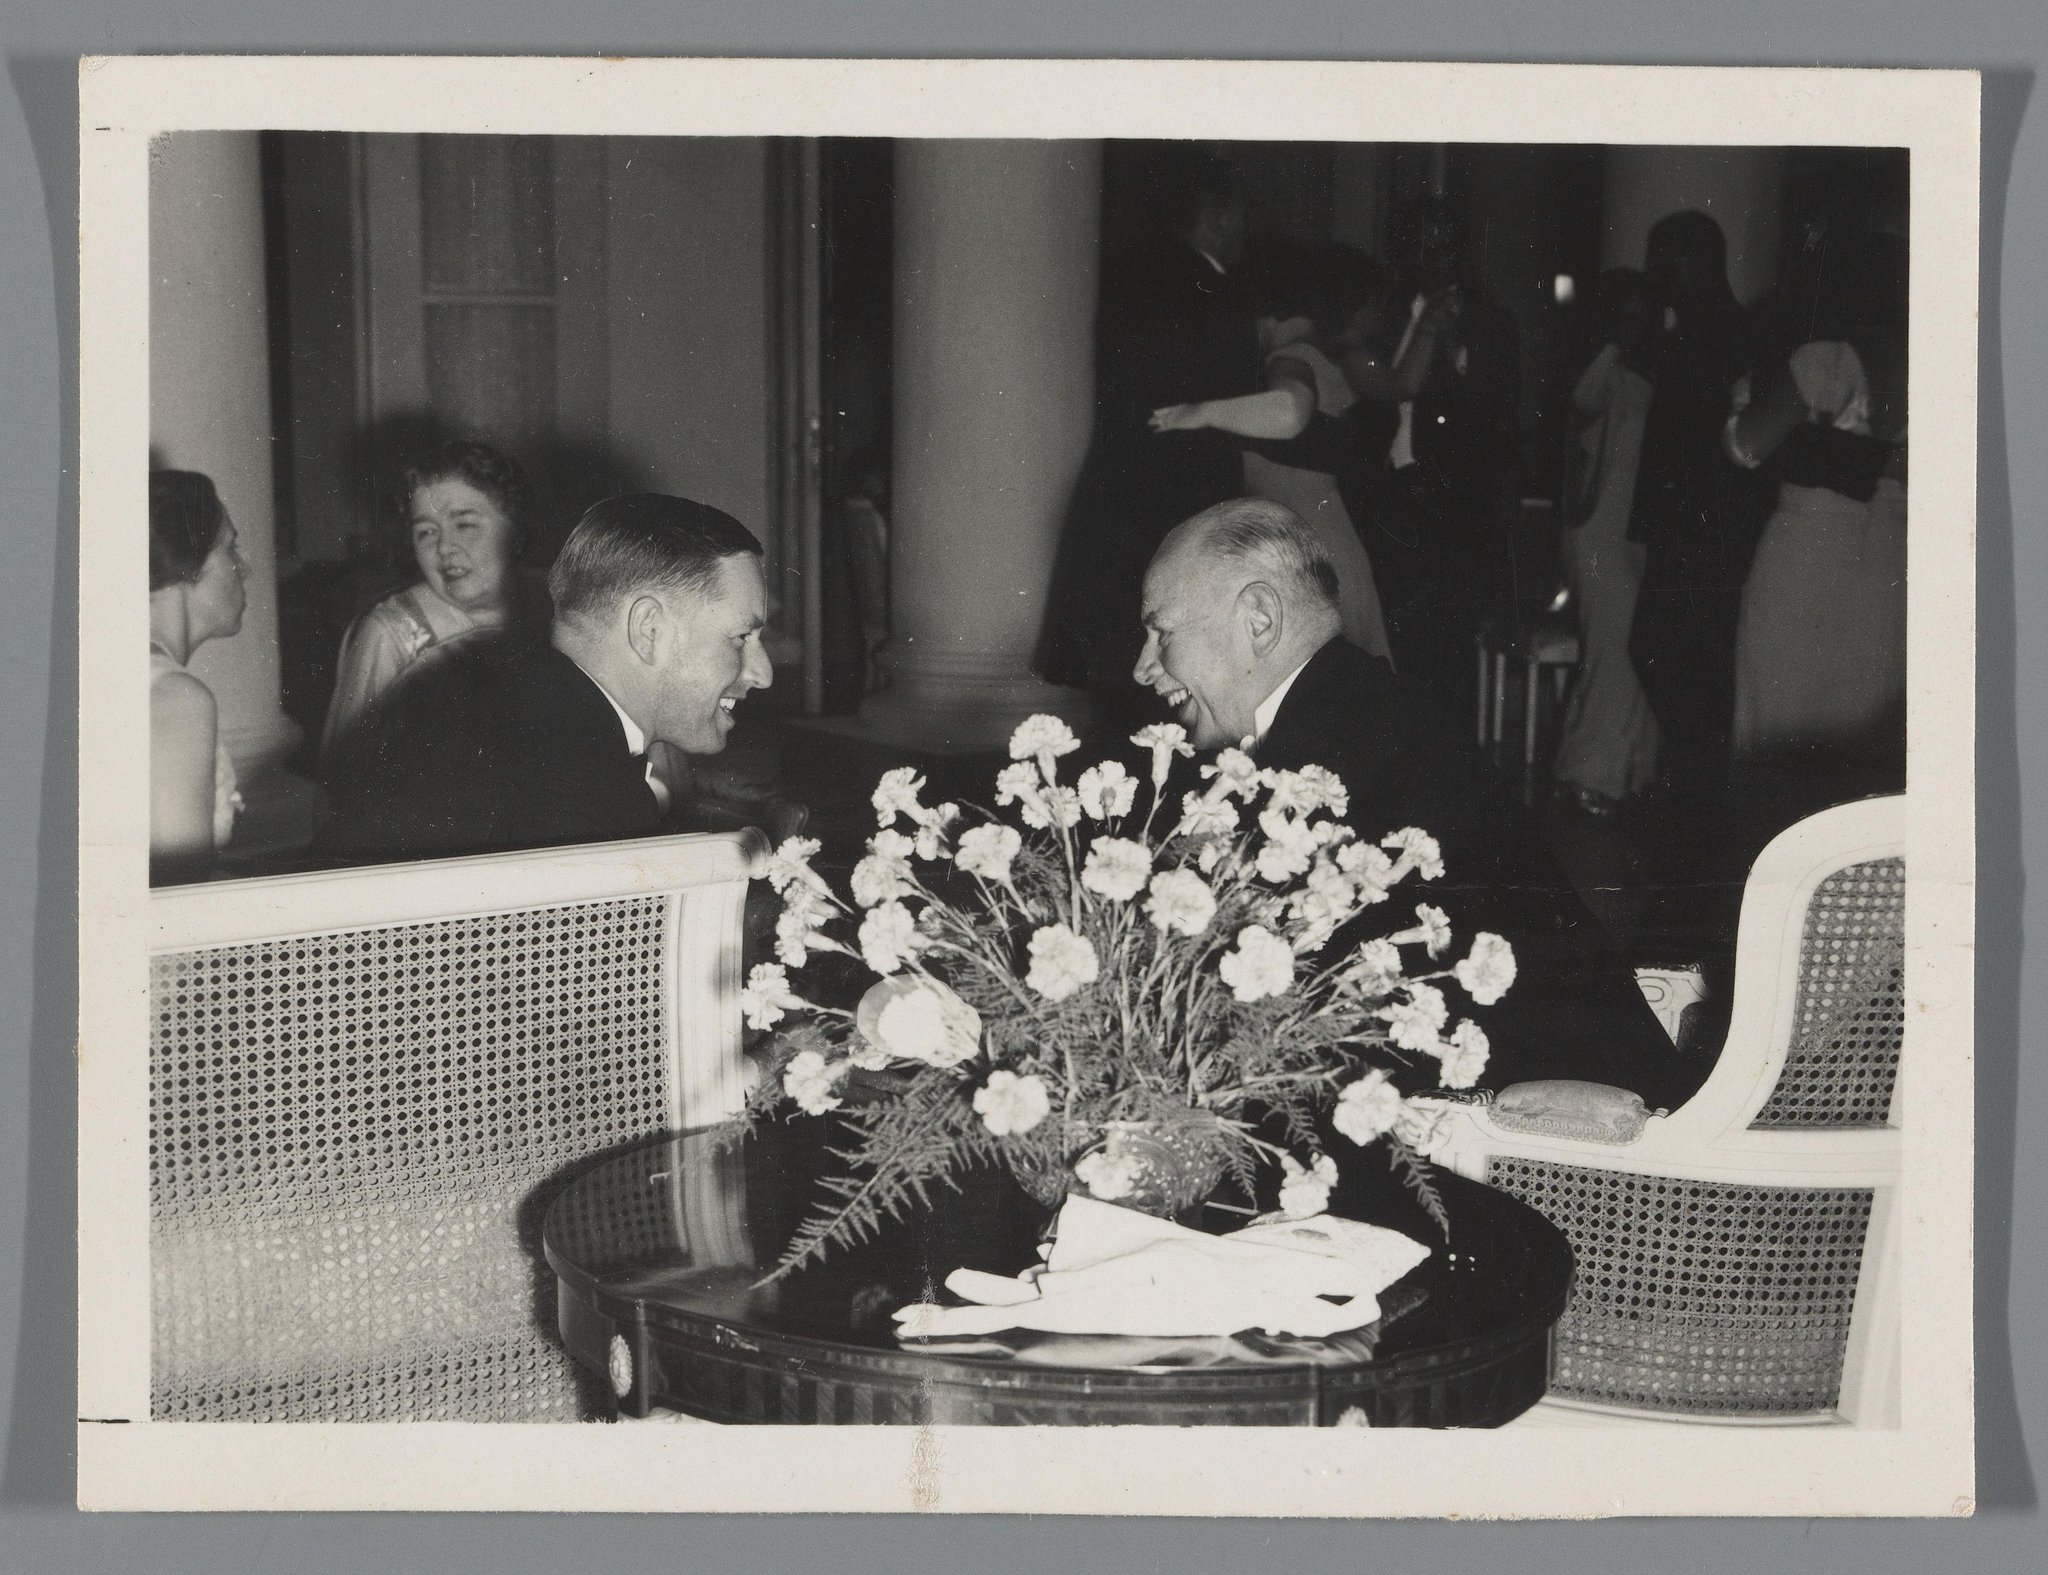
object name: photograph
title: Karel Frederik van den Berg zittend met een man achter een bos bloemen op een feestelijke gelegenheid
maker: Anonymous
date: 1935-1945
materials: photographic support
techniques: photography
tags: batavia, karel frederik van den berg